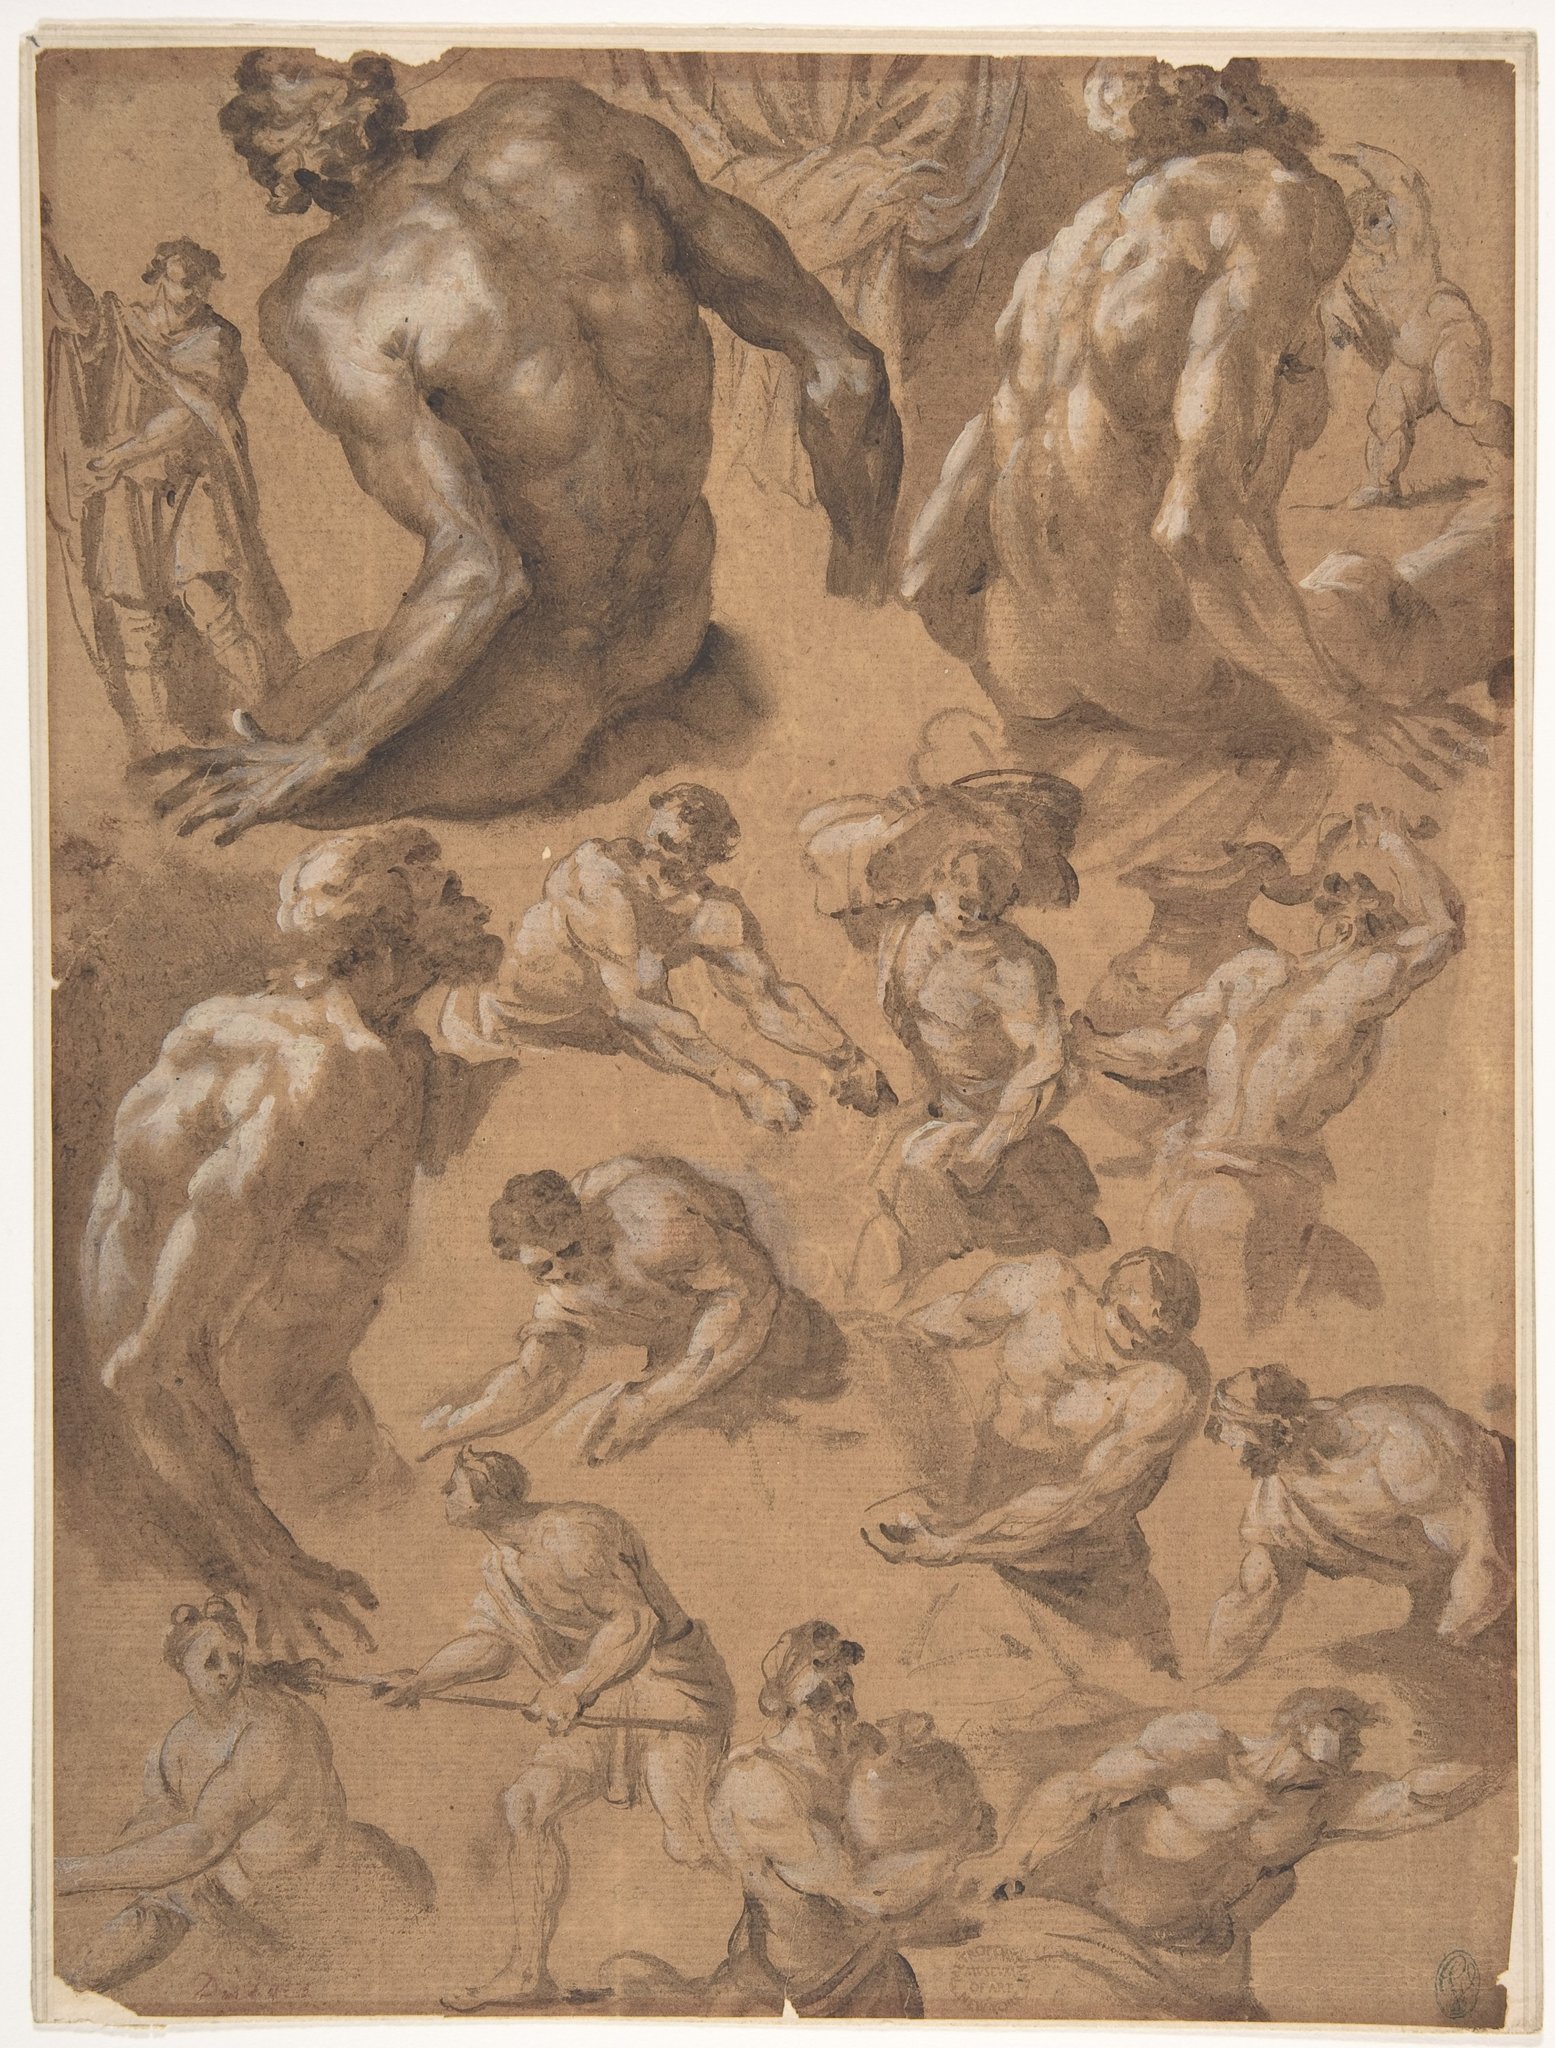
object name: drawing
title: Figure Studies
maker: eduard dubois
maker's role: artist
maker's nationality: flemish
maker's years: 1619-1697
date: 1601-1700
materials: paper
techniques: brush, heightening, wash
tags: men